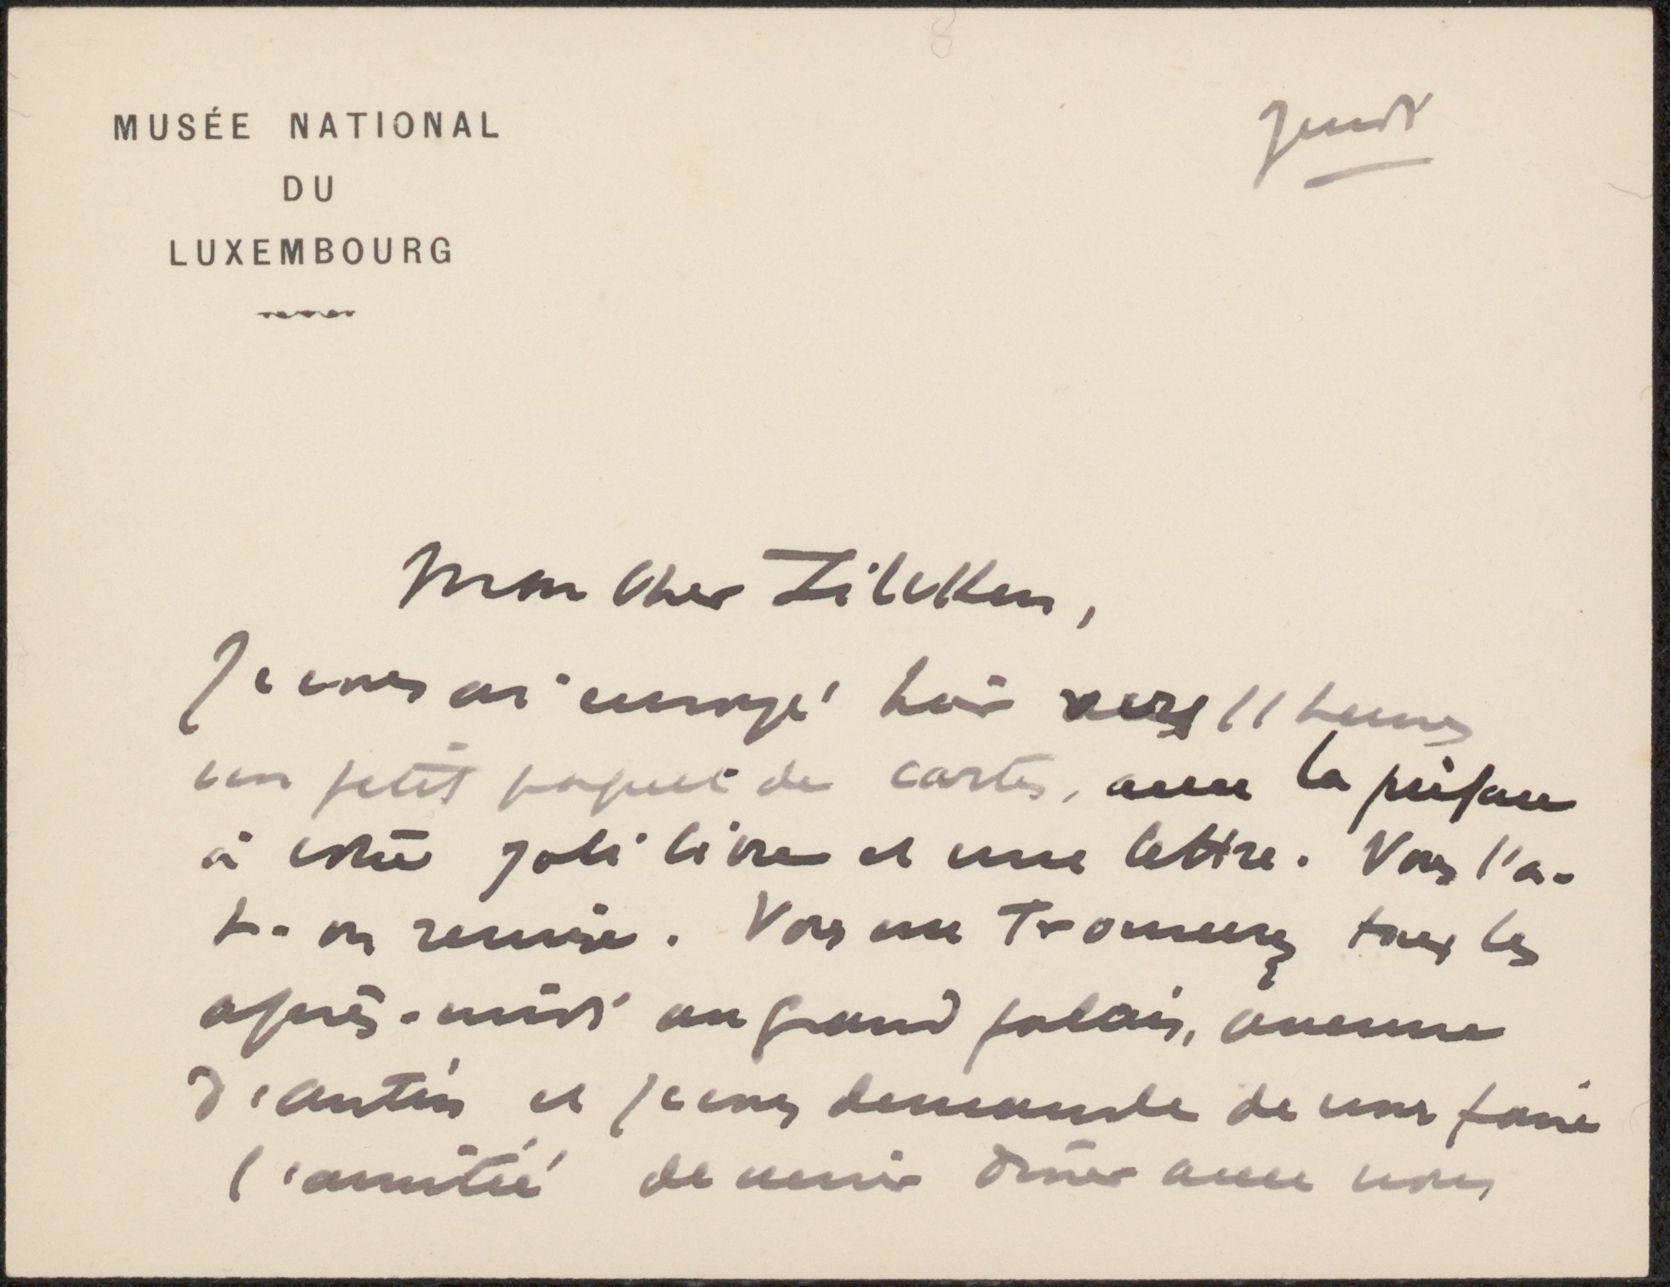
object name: letter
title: Brief aan Philip Zilcken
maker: léonce bénédite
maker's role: conservator, museumdirecteur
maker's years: 1856-1925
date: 1866-1925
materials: cardboard, ink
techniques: pen, printing, writing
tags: the hague, painter, draughtsman, philip zilcken, sending and receiving postal matter, printed matter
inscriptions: collector's mark: ‘RPK’